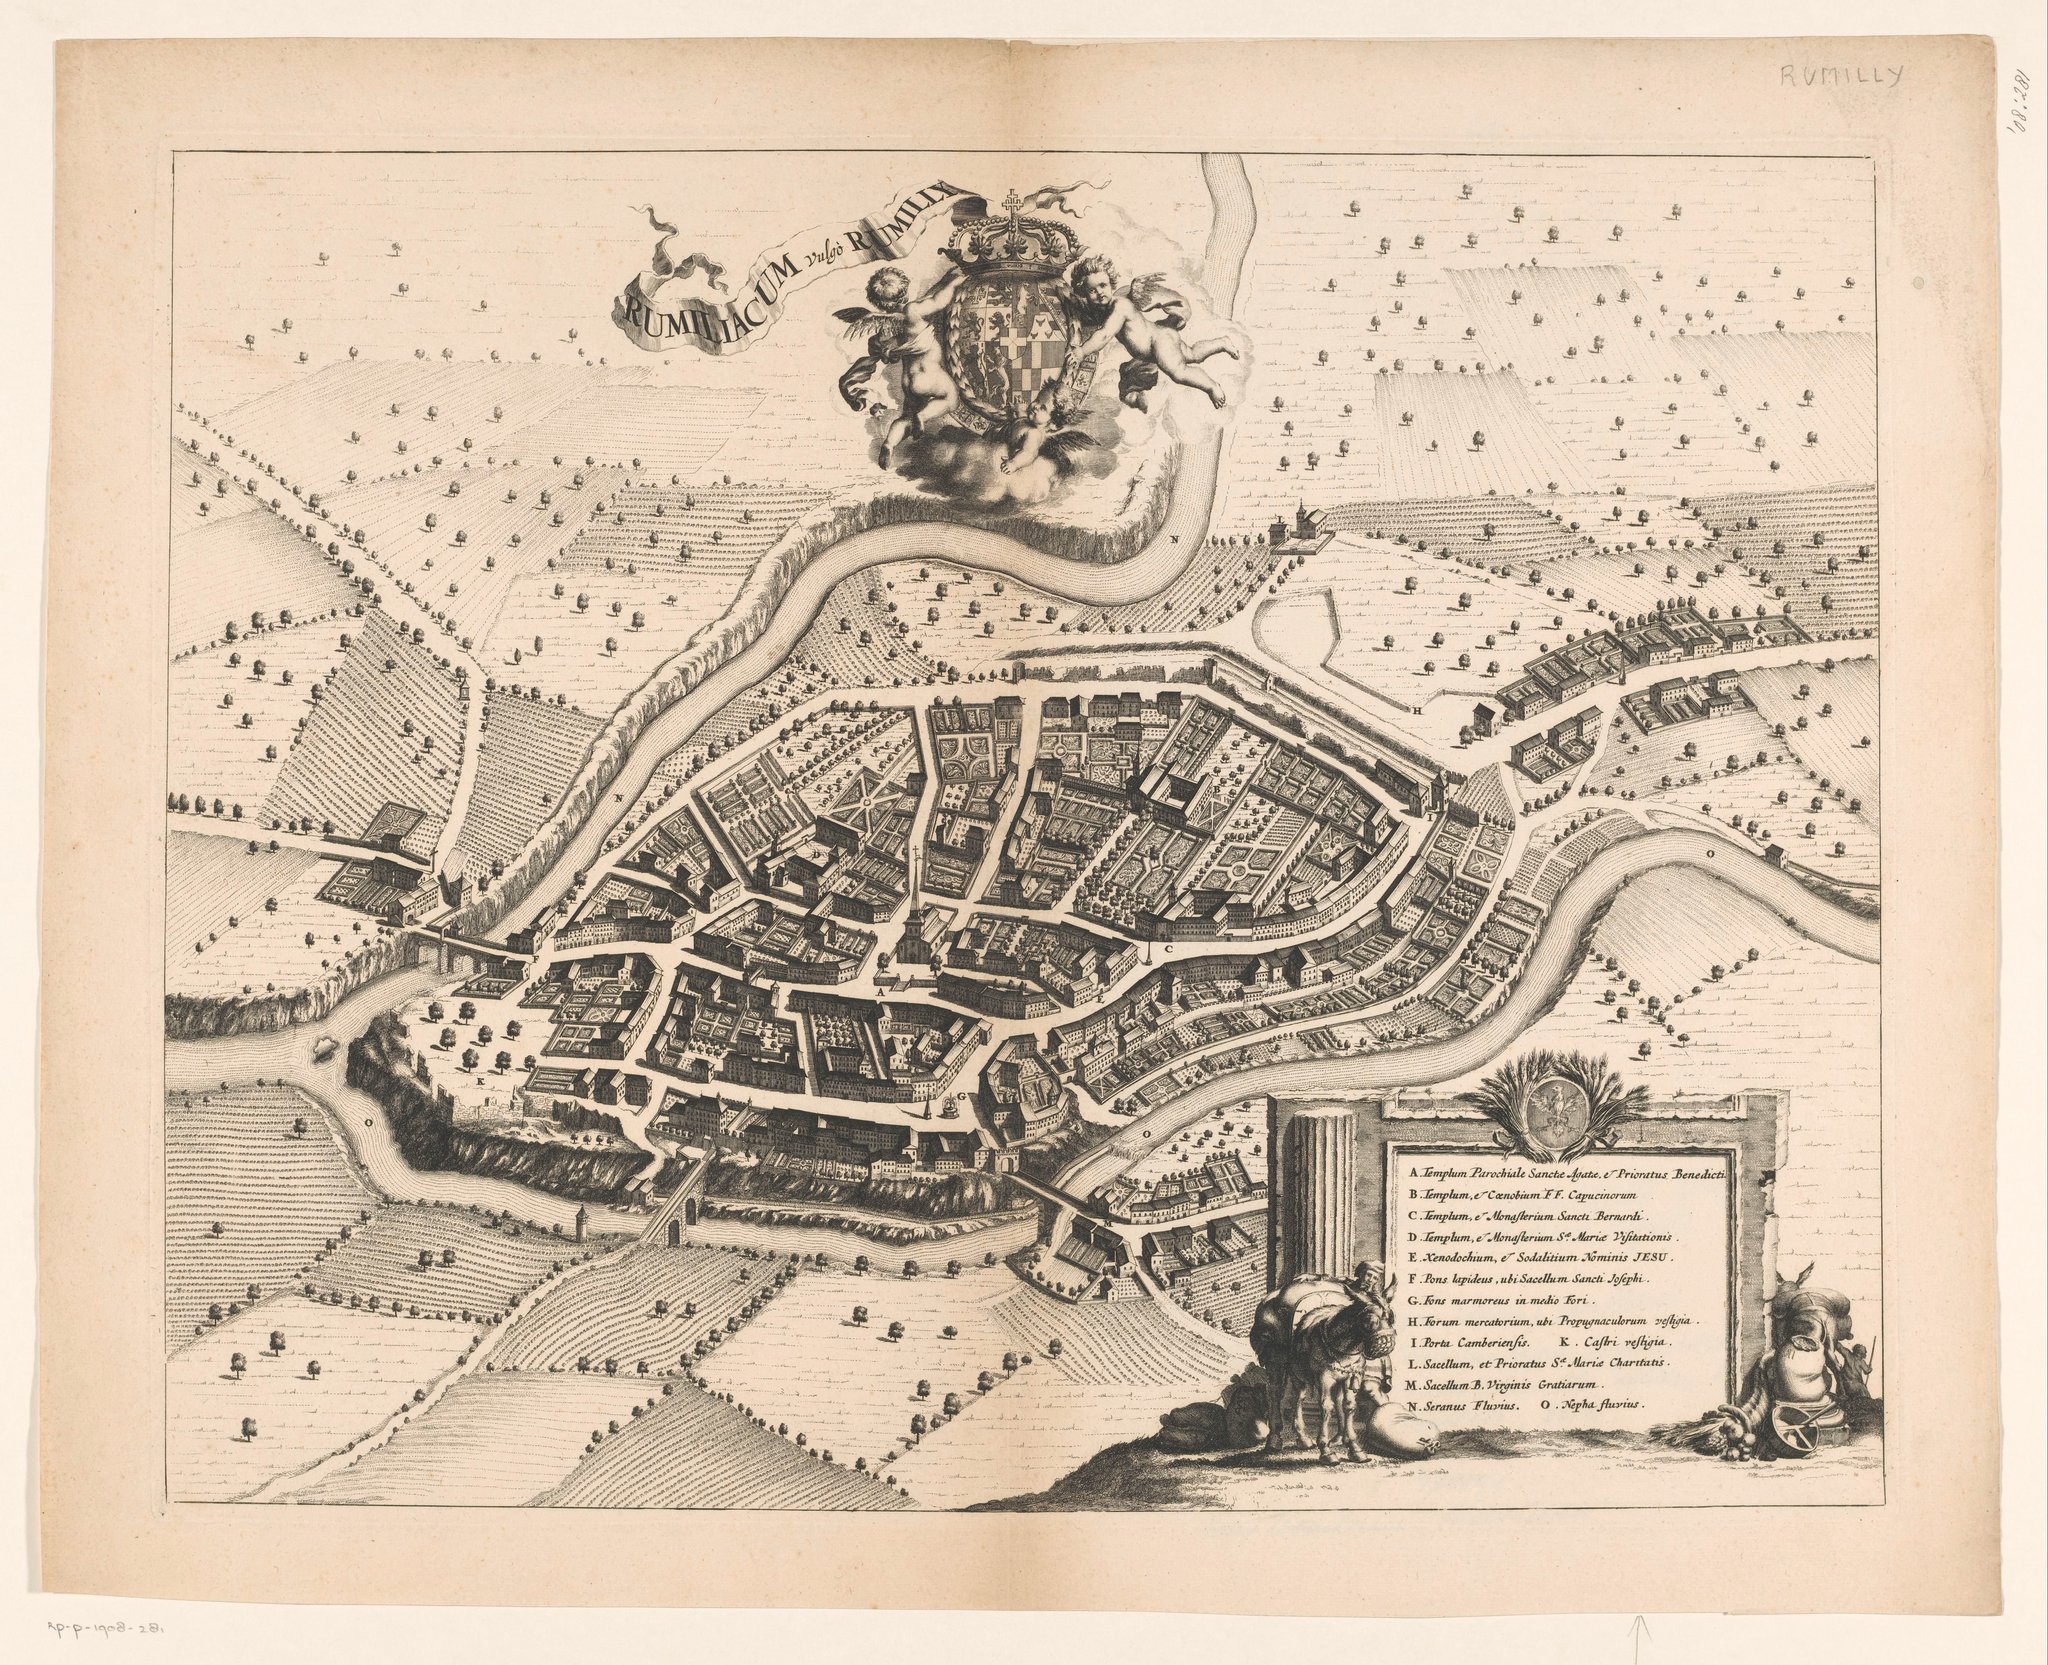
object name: bookplate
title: Search and research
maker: Anonymous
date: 1880-1939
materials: paper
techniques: printing block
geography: england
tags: measuring-instruments, globe, cupids: 'amores', 'amoretti', 'putti'